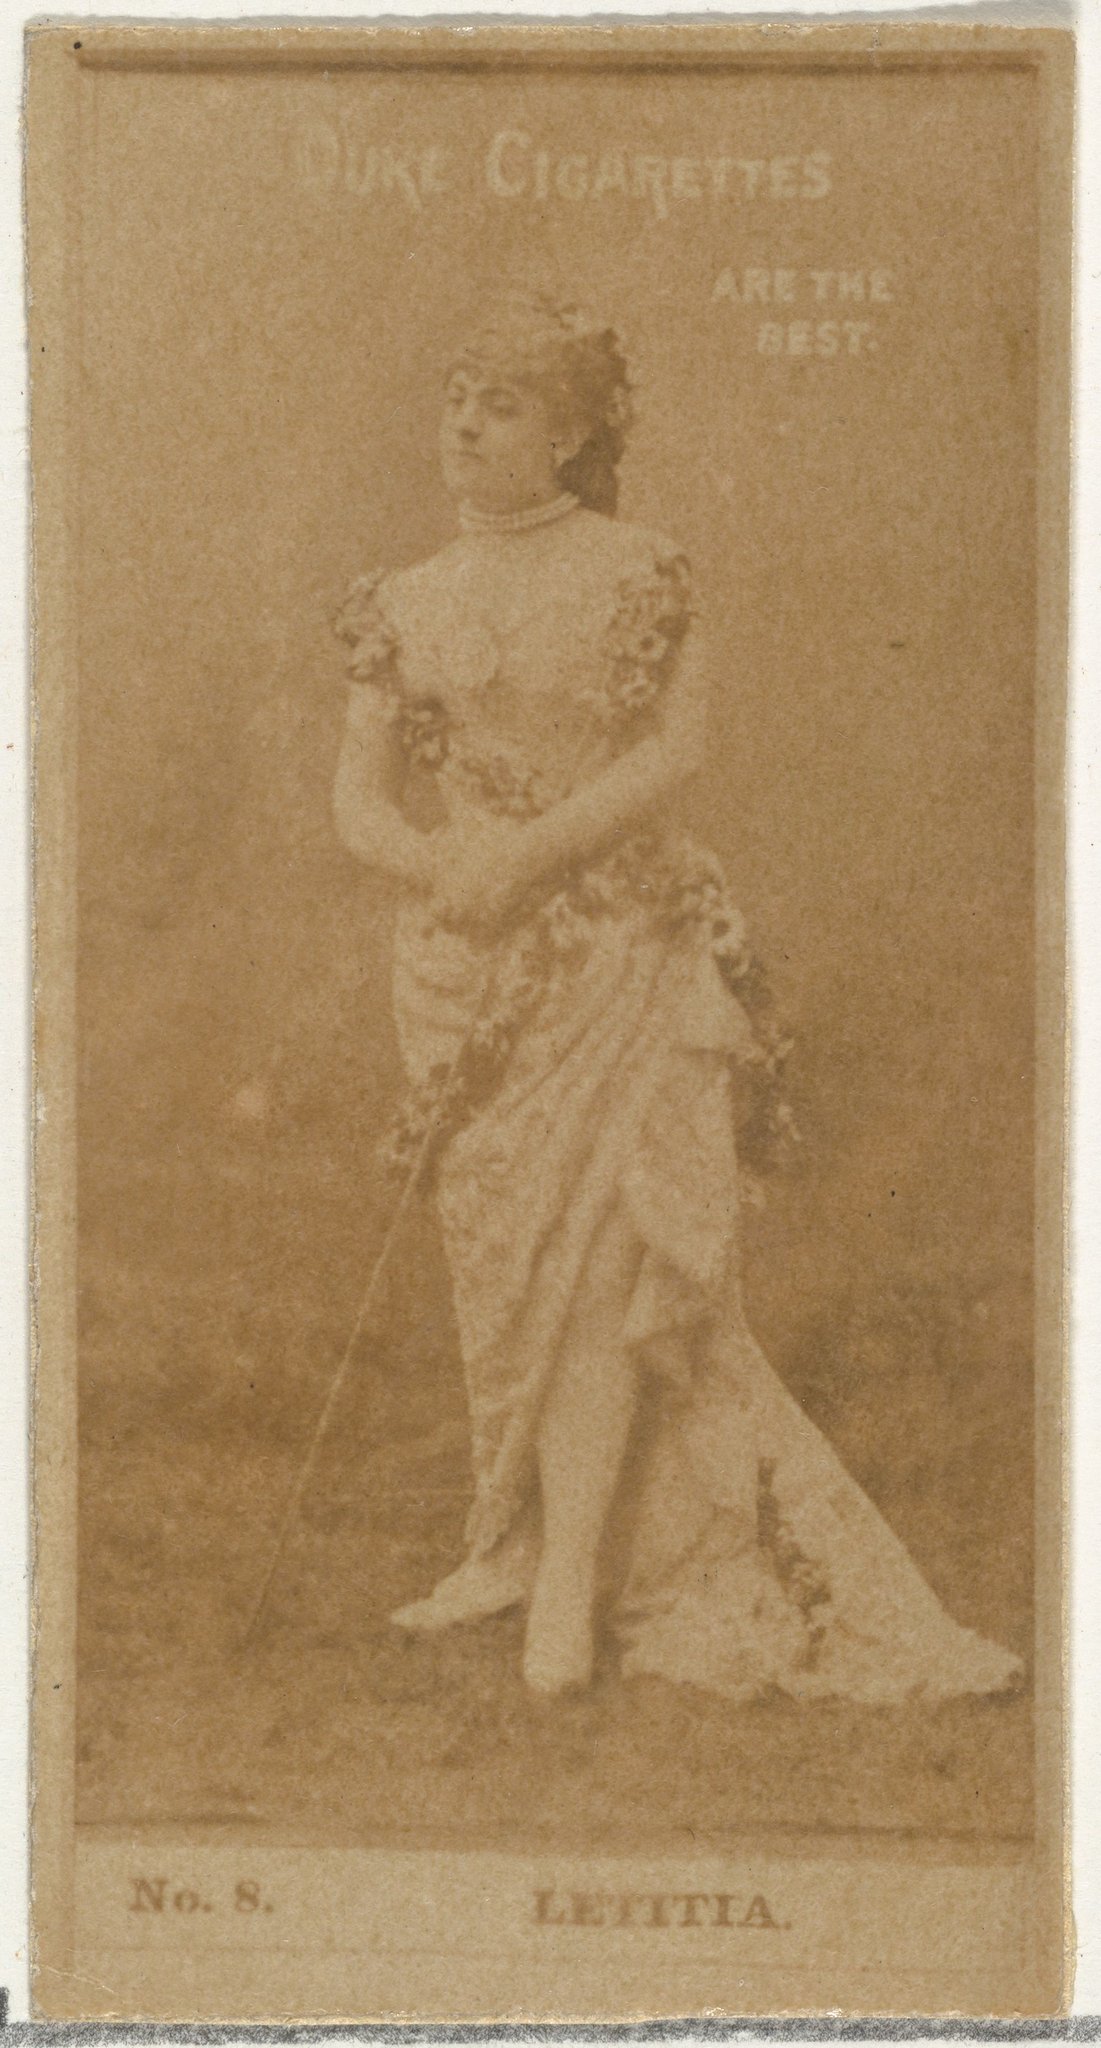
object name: photograph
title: Card Number 8, Letitia, from the Actors and Actresses series (N145-6) issued by Duke Sons & Co. to promote Duke Cigarettes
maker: w. duke, sons & co.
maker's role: publisher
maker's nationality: american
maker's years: 1870-1920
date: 1880-1889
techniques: albumen silver print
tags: portraits,women,actresses